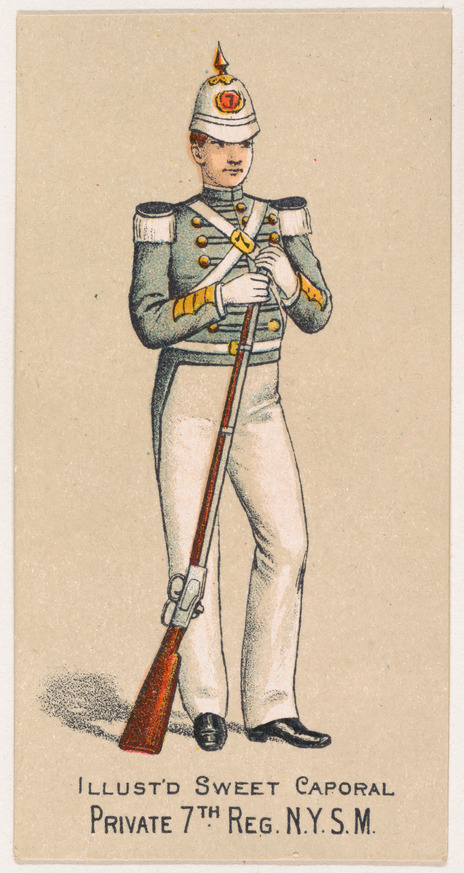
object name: print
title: Private, 7th Regiment, New York State Militia, from the Military Series (N224) issued by Kinney Tobacco Company to promote Sweet Caporal Cigarettes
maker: kinney brothers tobacco company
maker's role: publisher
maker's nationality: american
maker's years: 1869-2011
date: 1888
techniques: color lithograph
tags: military,firearms,men